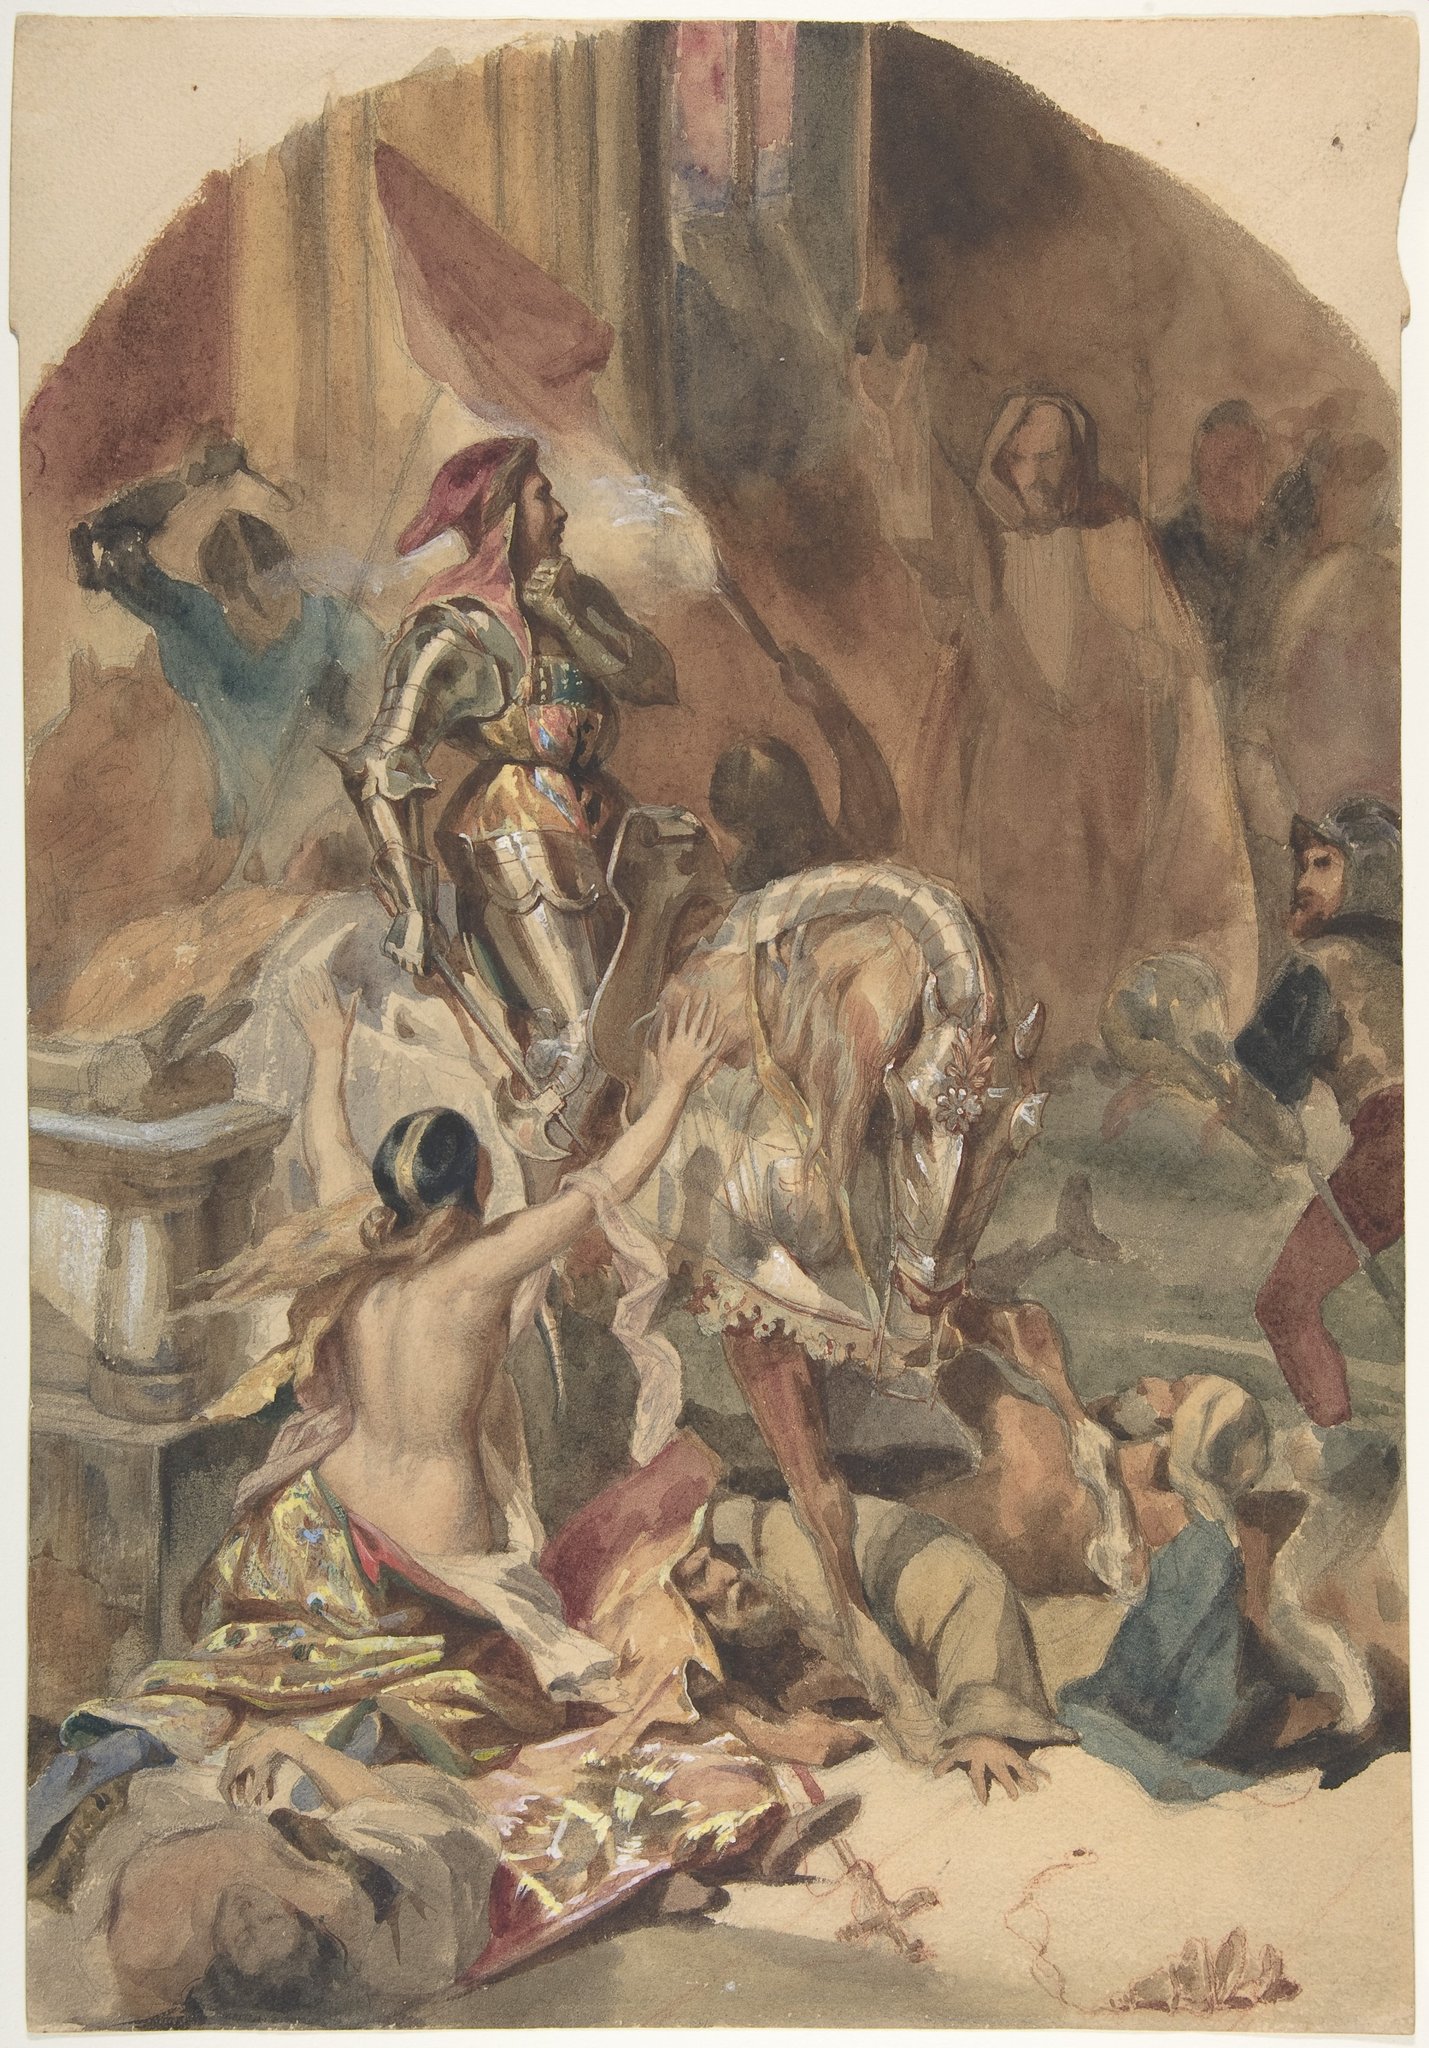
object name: drawing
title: Massacre de Nesle (1472)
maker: edouard-alexandre odier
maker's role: artist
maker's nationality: french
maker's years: 1800-1887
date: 1801-1900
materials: chalk, gouache, graphite, watercolor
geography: france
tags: massacres,men,women,horses,axes